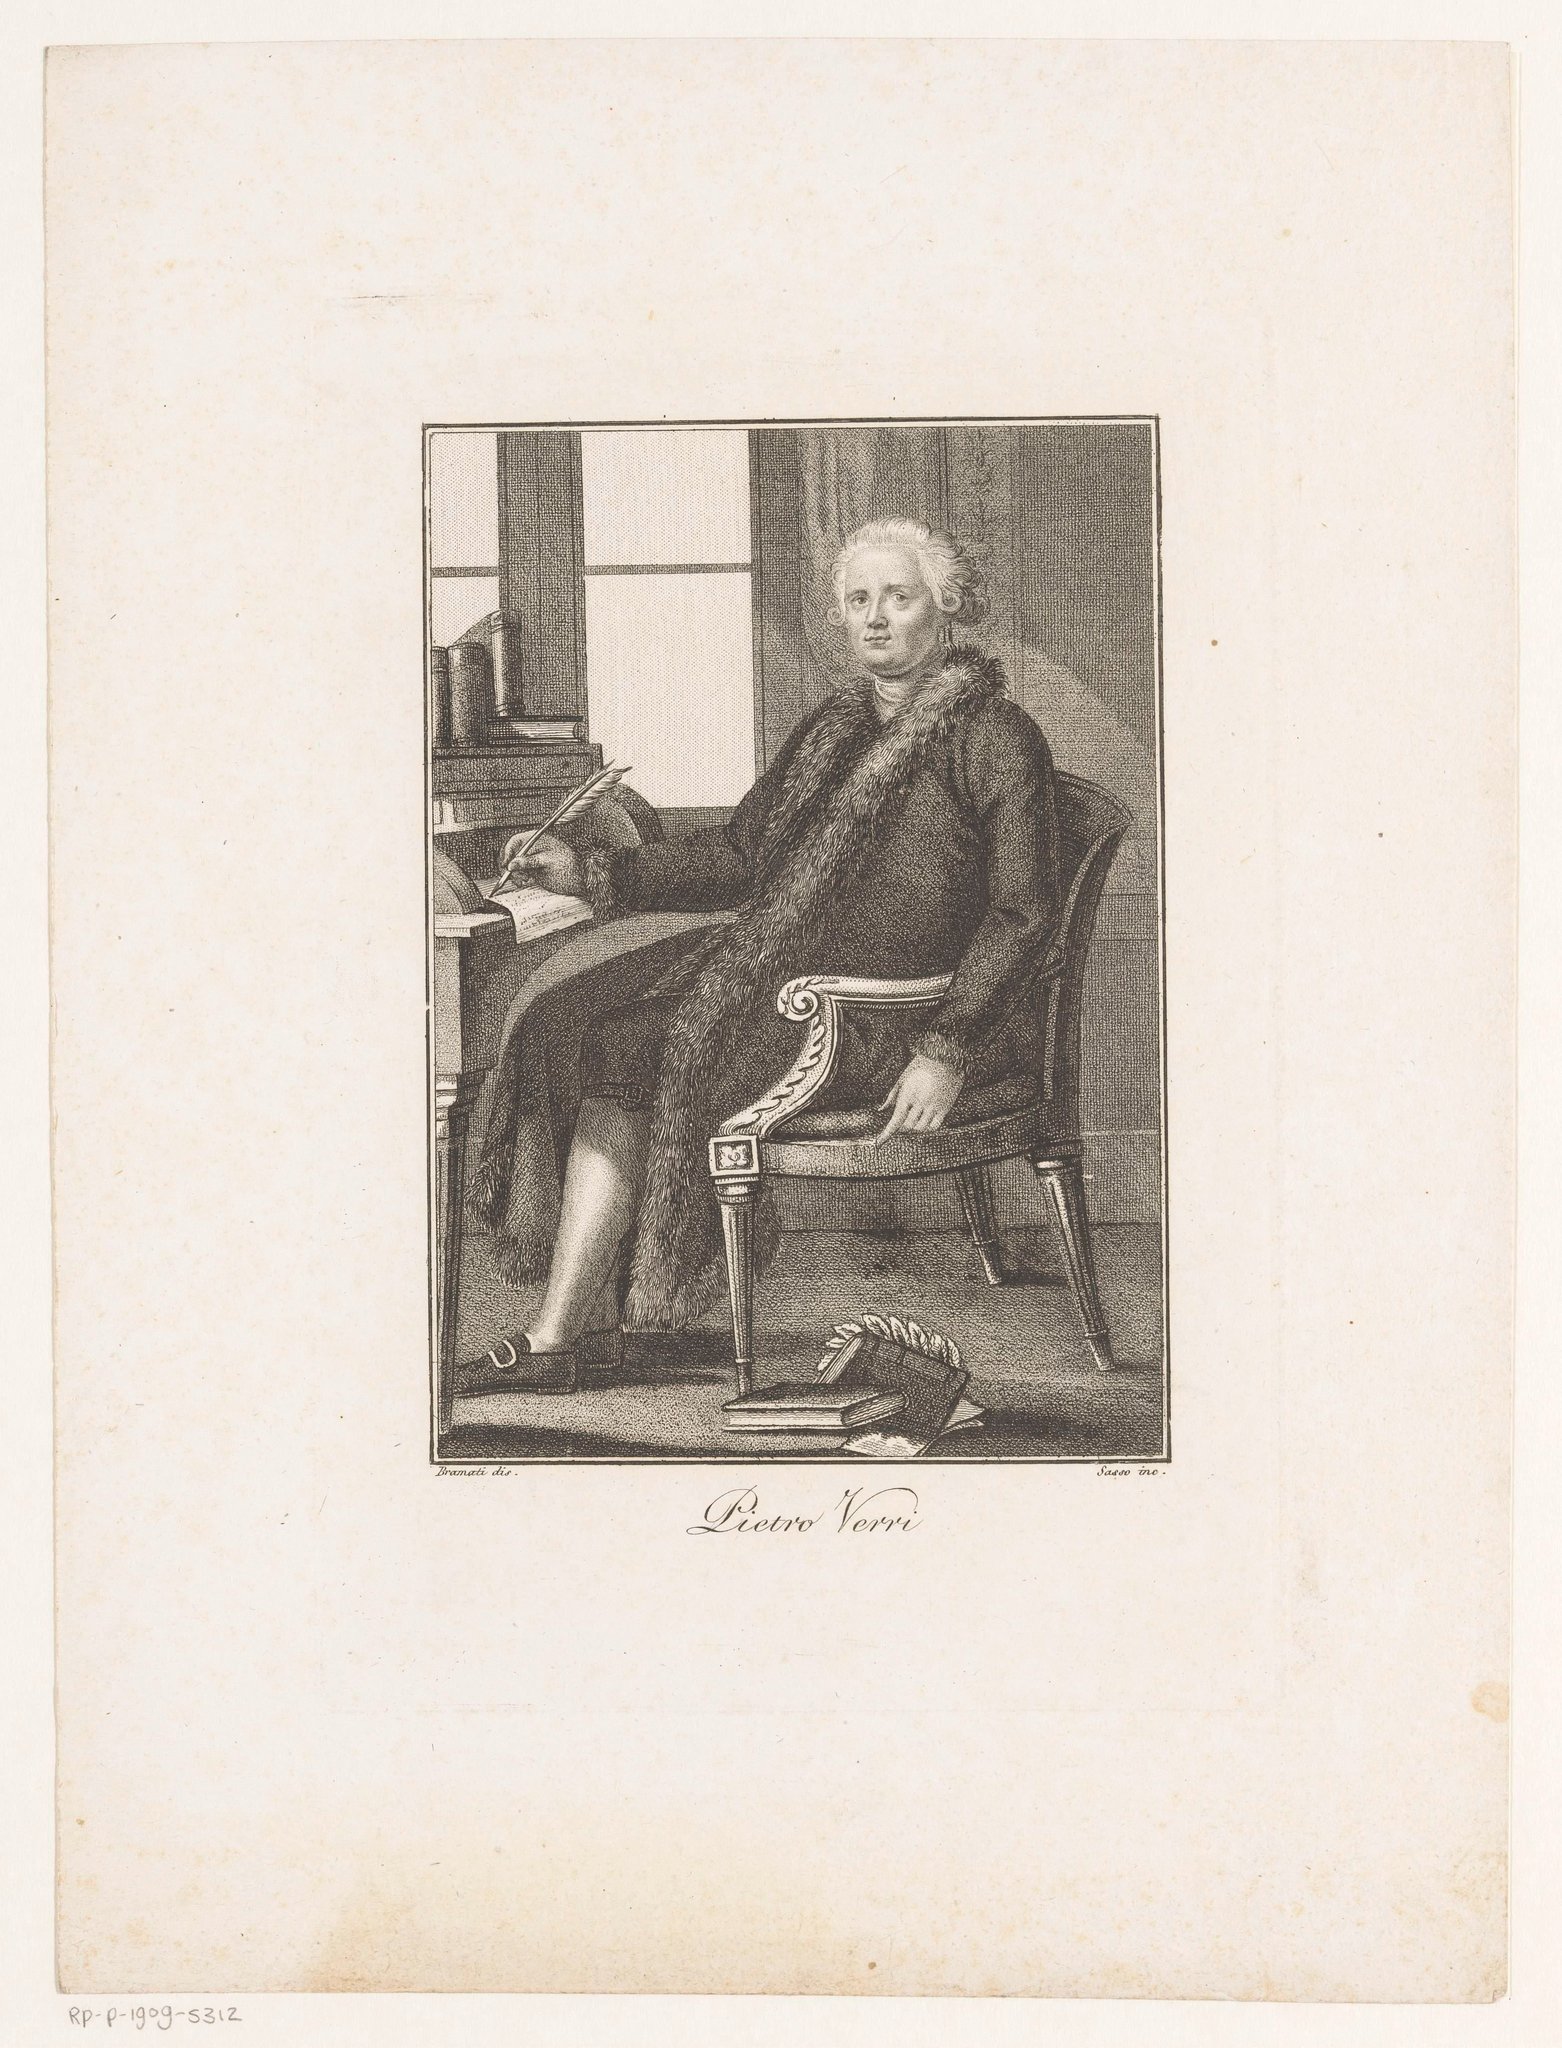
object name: print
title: Portret van filosoof en econoom Pietro Verri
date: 1809-1816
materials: paper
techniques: engraving, etching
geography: italy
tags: historical persons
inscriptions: collector's mark: Lugt 2228